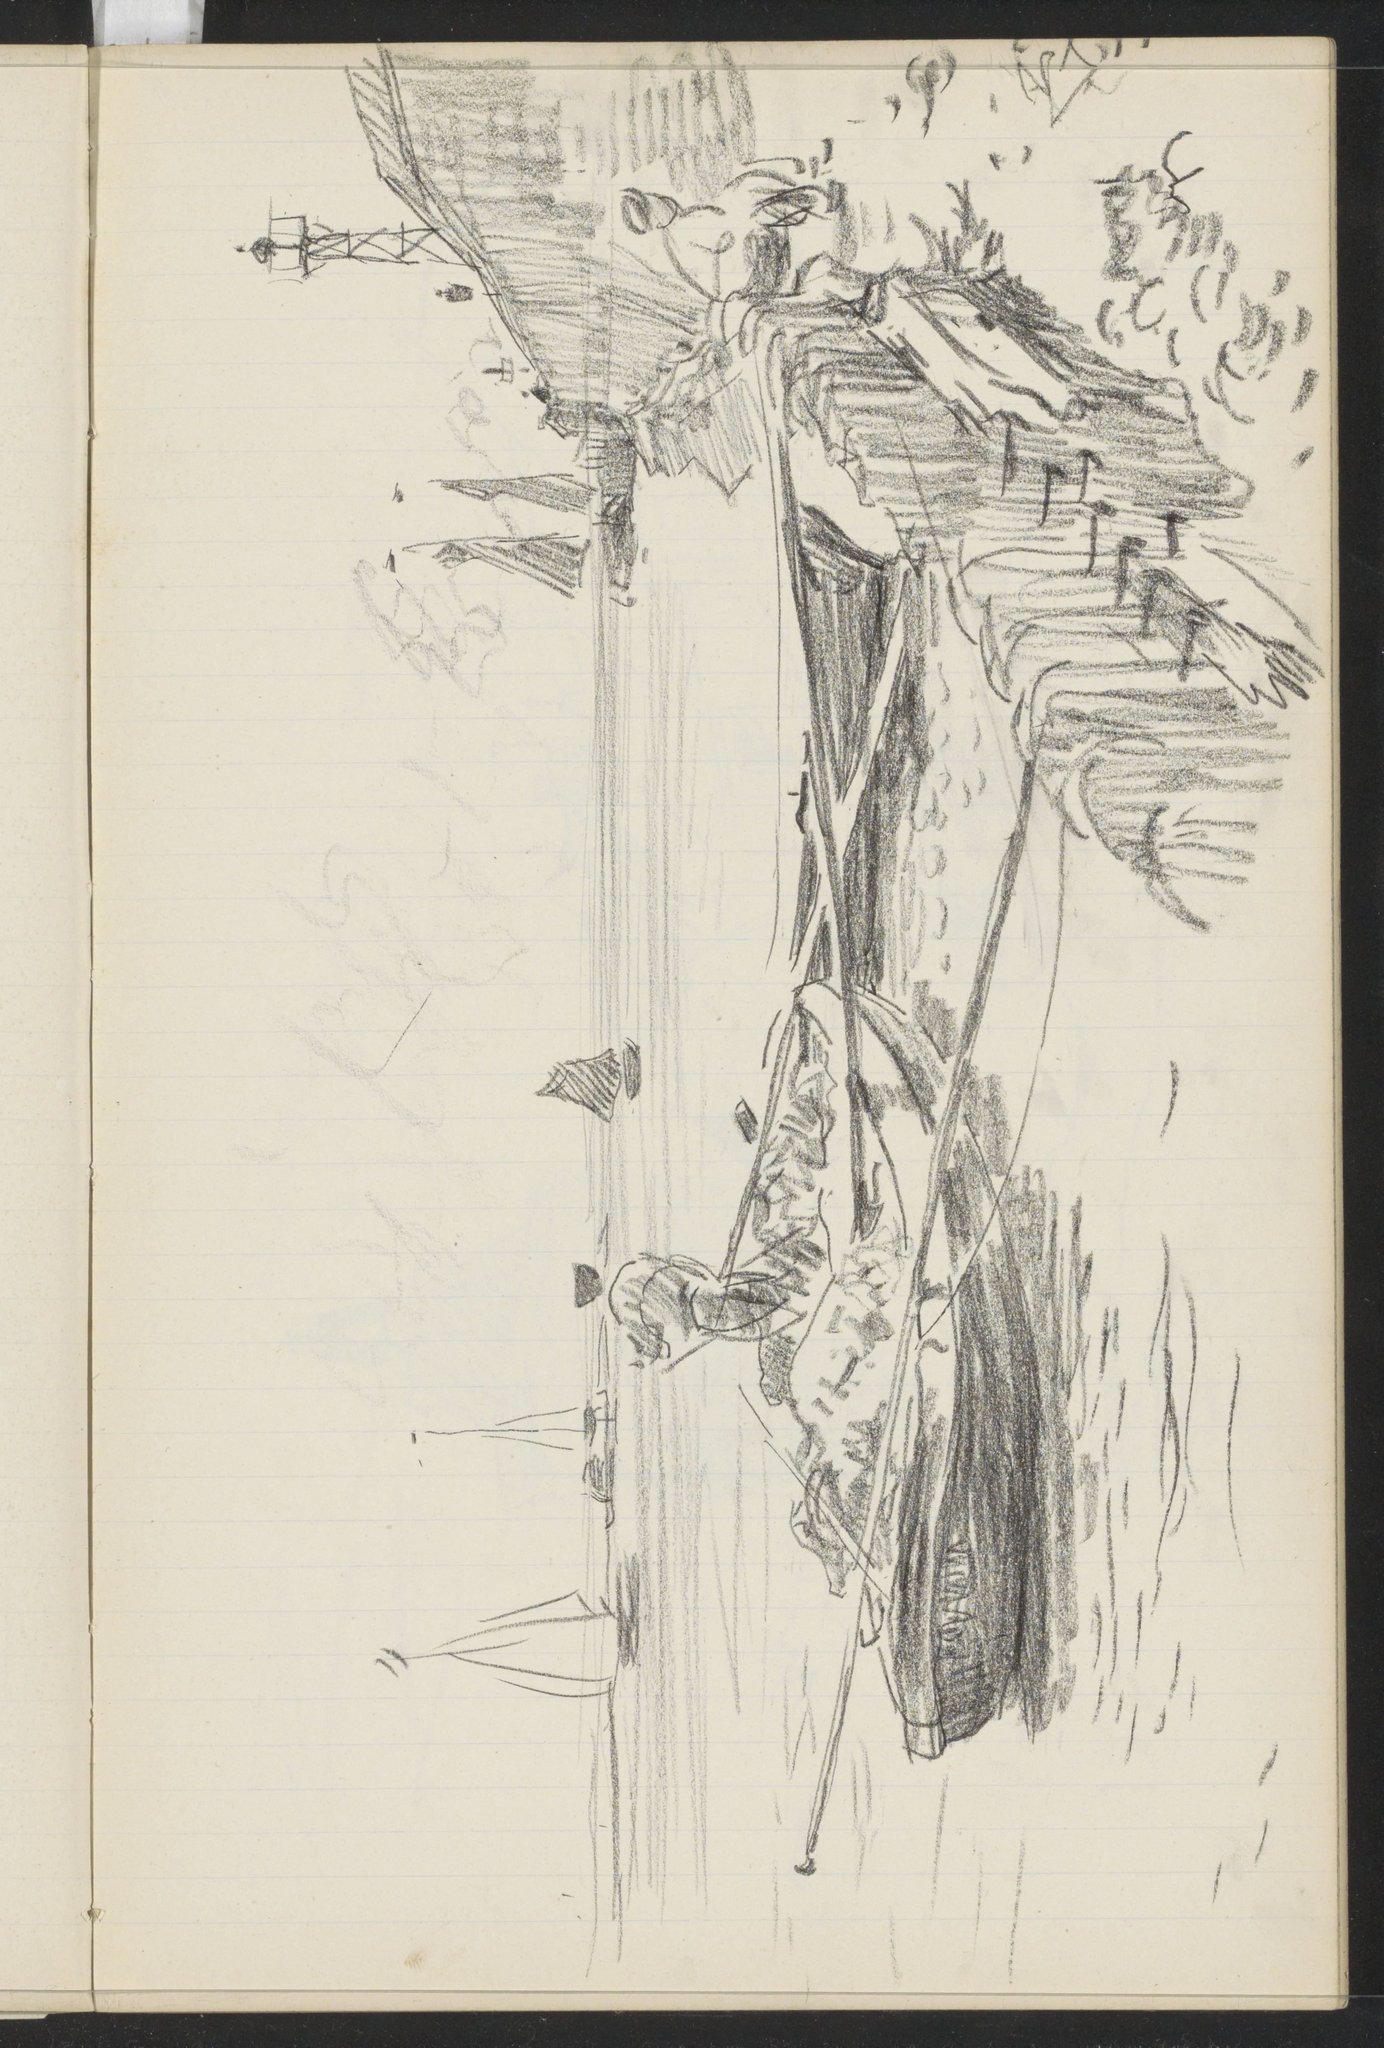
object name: sketchbook leaf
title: Aanmerende vissersboot bij een kade, mogelijk in Enkhuizen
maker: willem bastiaan tholen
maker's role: draughtsman, painter, print maker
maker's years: 1860-1931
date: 1900-1931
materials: chalk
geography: enkhuizen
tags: lighthouse, lightship, sailing-ship, sailing-boat, landscapes with waters, waterscapes, seascapes (in the temperate zone), quay, enkhuizen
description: Op de achtergrond zijn een vuurtoren op de kade en enkele zeilschepen op zee te zien. Blad 19 recto uit een schetsboek met 55 bladen.